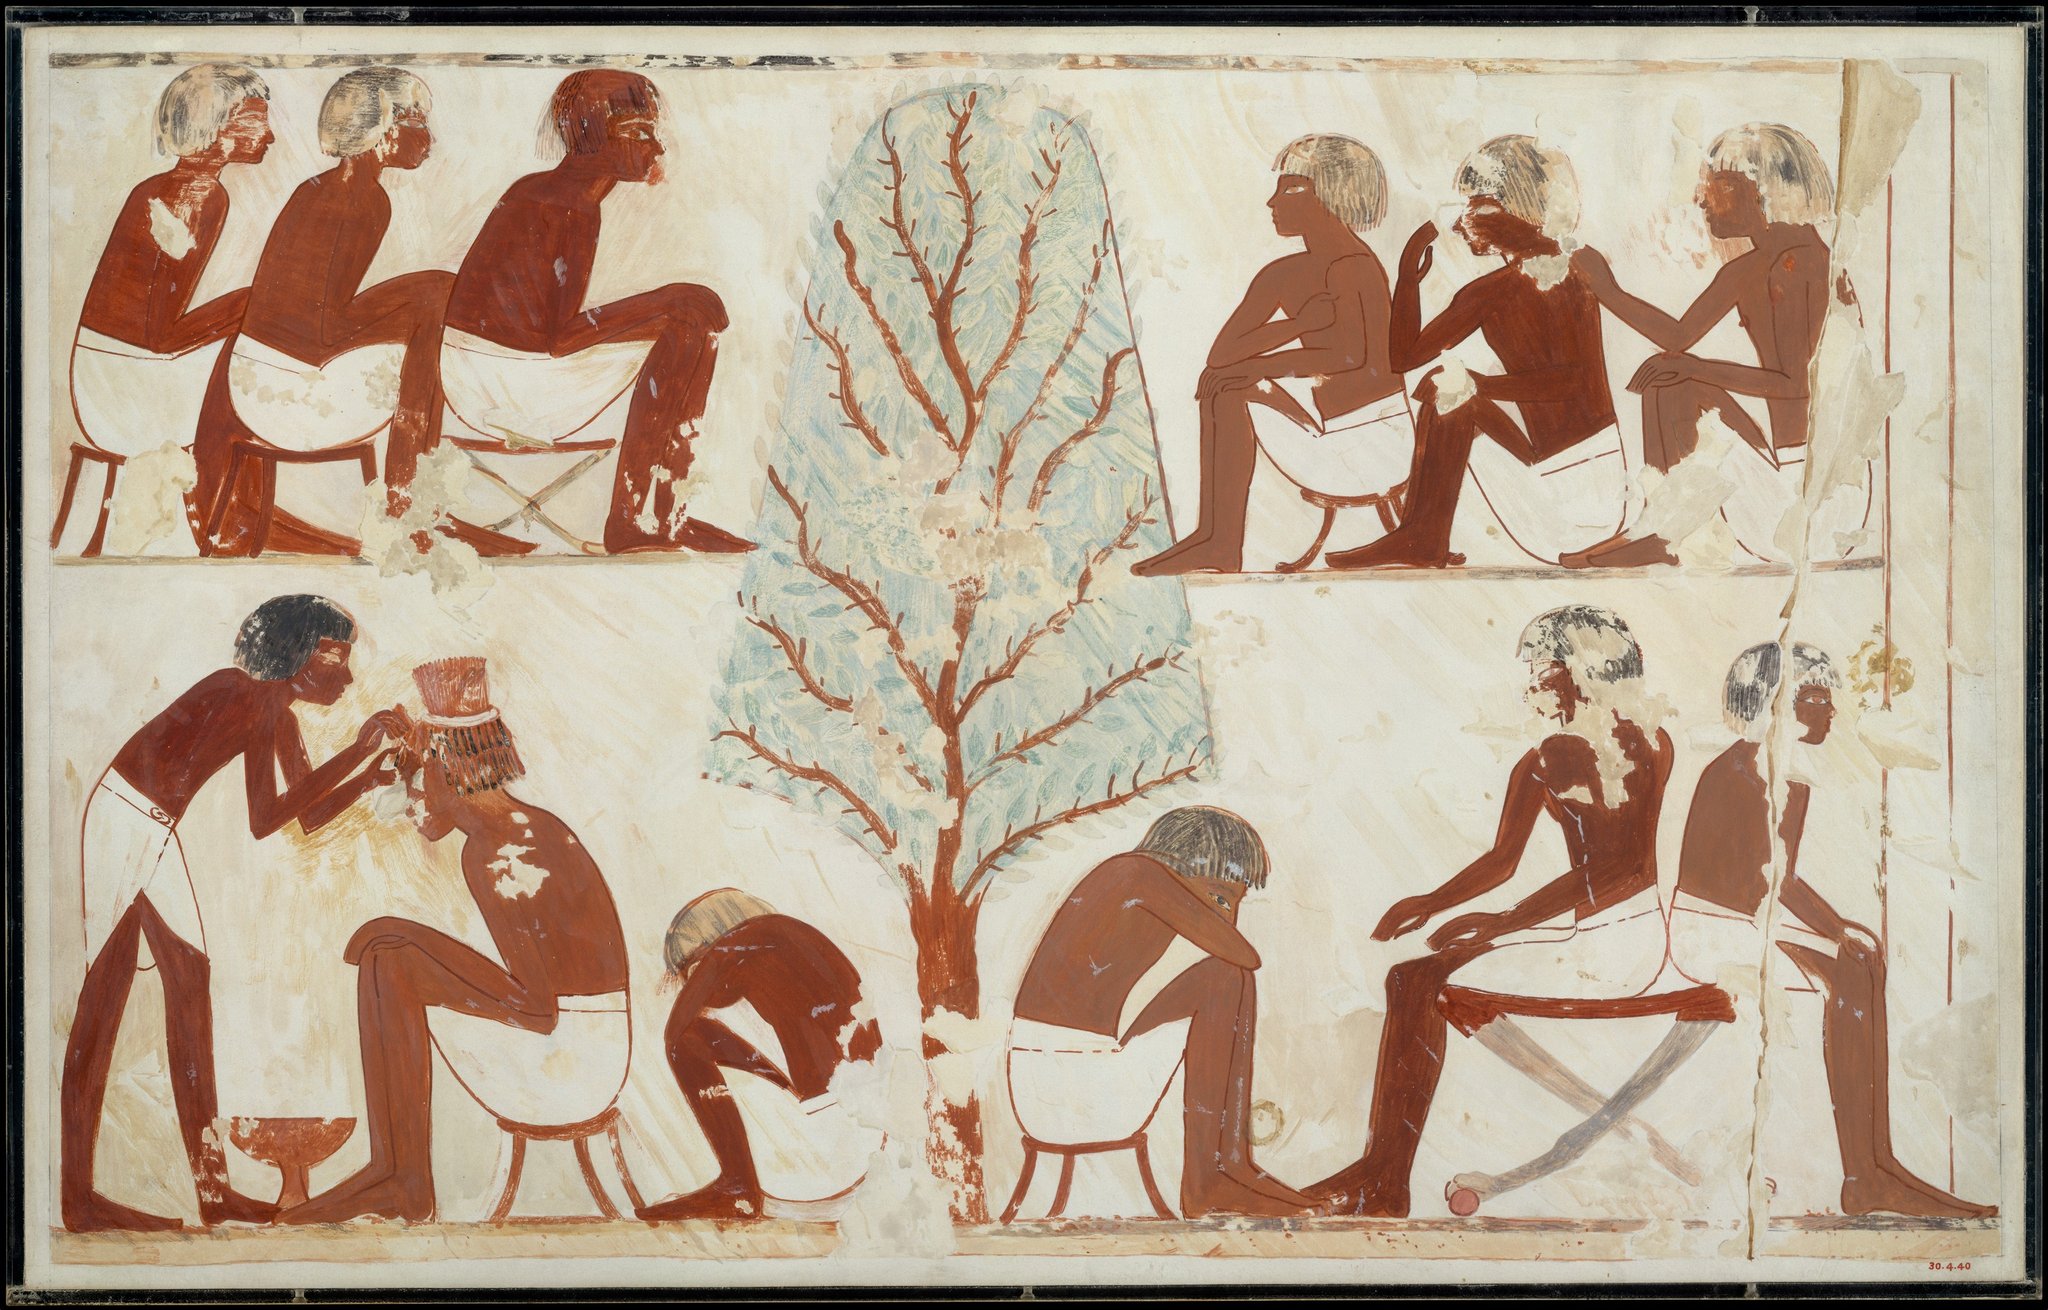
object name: facsimile, userhat tt 56, barber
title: A Barber at Work and Men Waiting Their Turn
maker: nina de garis davies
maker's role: artist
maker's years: 1881-1965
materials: paper, paint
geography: egypt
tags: men